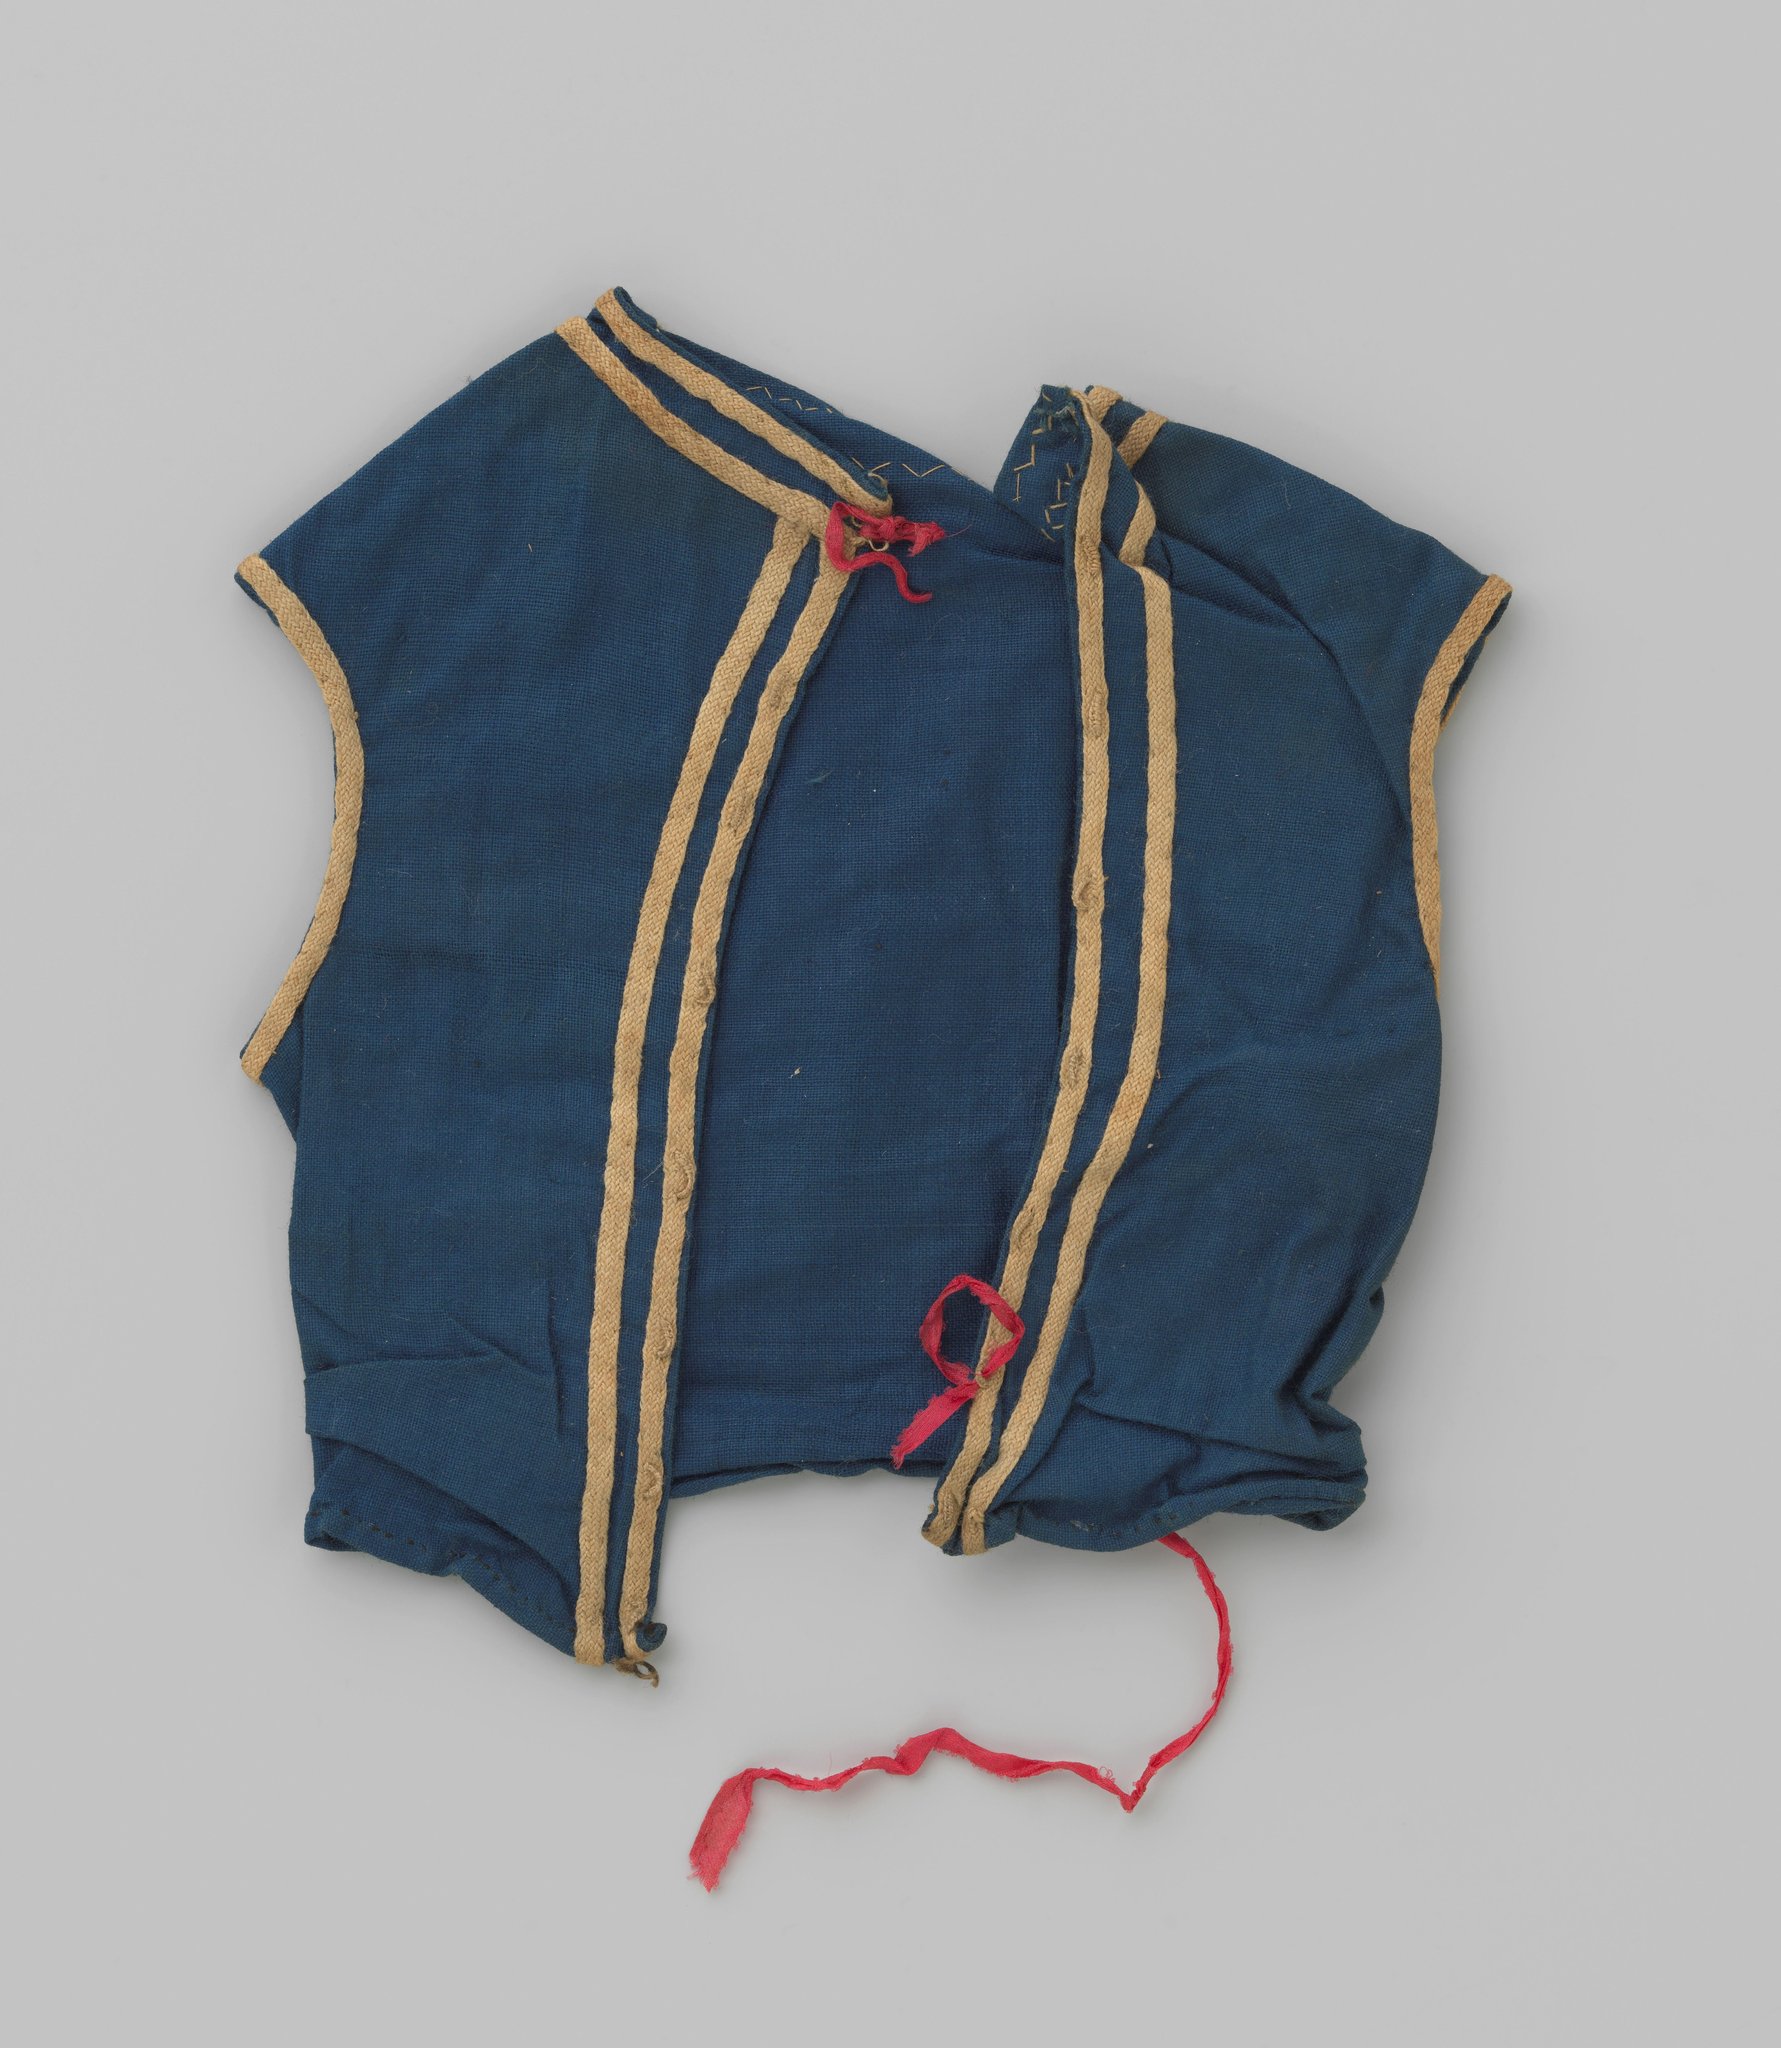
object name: doll's clothing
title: Hes van blauw katoen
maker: Anonymous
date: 1850-1920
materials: cotton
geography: netherlands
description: Hes van blauw katoen met witte biesjes en een rode vetersluiting.